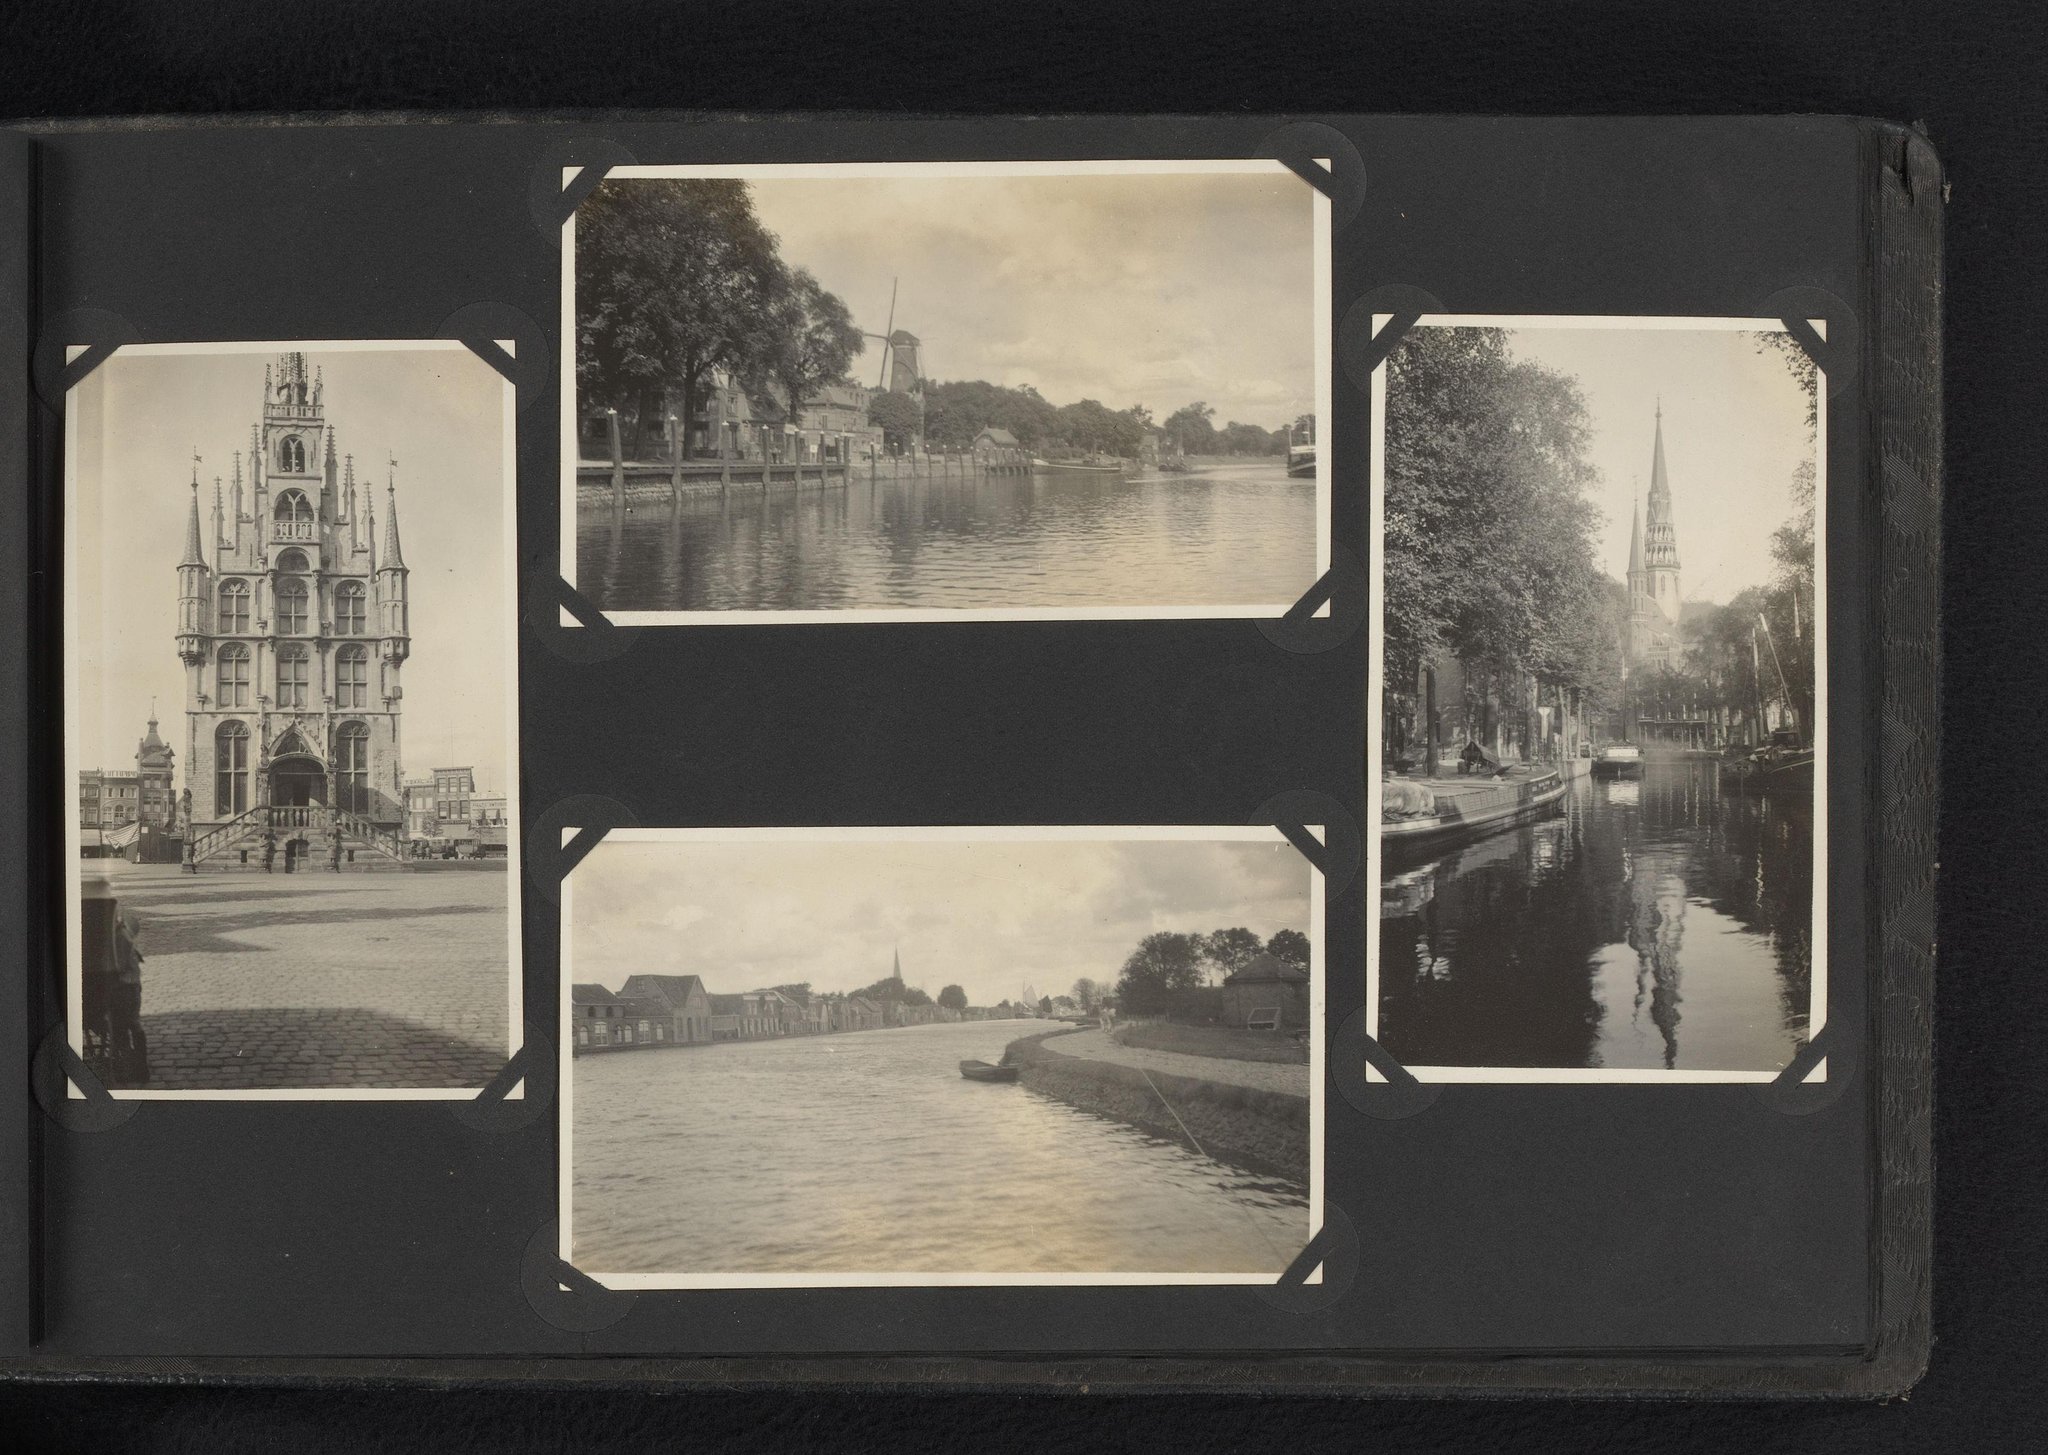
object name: photograph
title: Vier foto's van het stadhuis van Gouda en rivieren in Nederland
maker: hendrik herman van den berg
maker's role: amateurfotograaf, jurist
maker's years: 1875-1944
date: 1926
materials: paper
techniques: gelatin silver print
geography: netherlands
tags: river, townhall, netherlands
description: Deze foto's maken deel uit van een album.